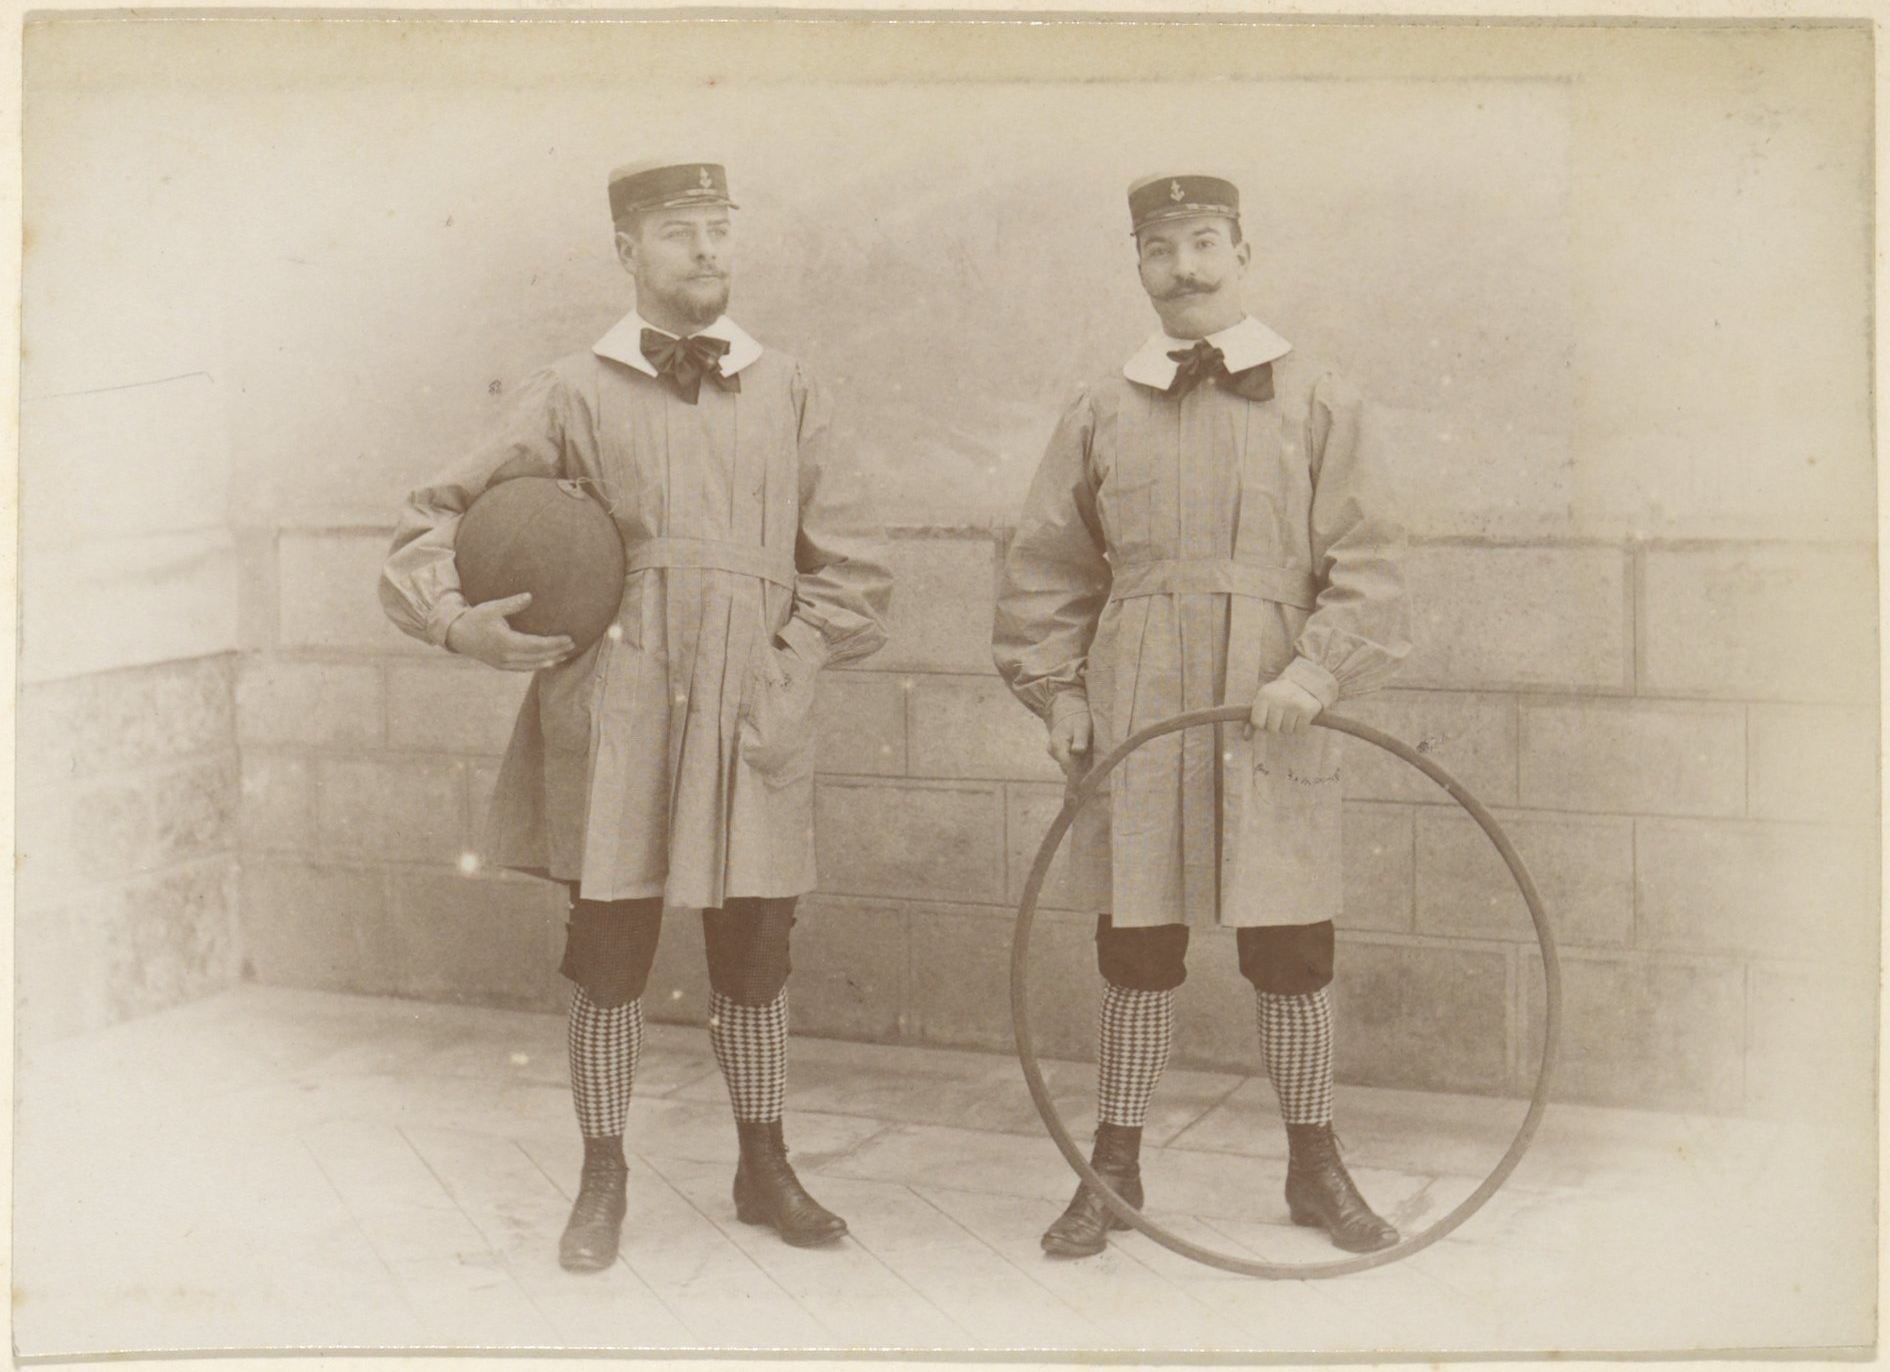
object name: photograph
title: Twee Franse mannen verkleed in kinderkleding met hoepel en bal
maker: Anonymous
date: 1900-1910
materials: paper, photographic support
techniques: albumen print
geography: france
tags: dress-up party, adult man, (bowling a) hoop, ball games, france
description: Onderdeel van Fotoalbum van een Franse amateurfotograaf met opnames van een familie, distilleerderij Delizy & Doistau Fils, het leger en bezienswaardigheden in Frankrijk.